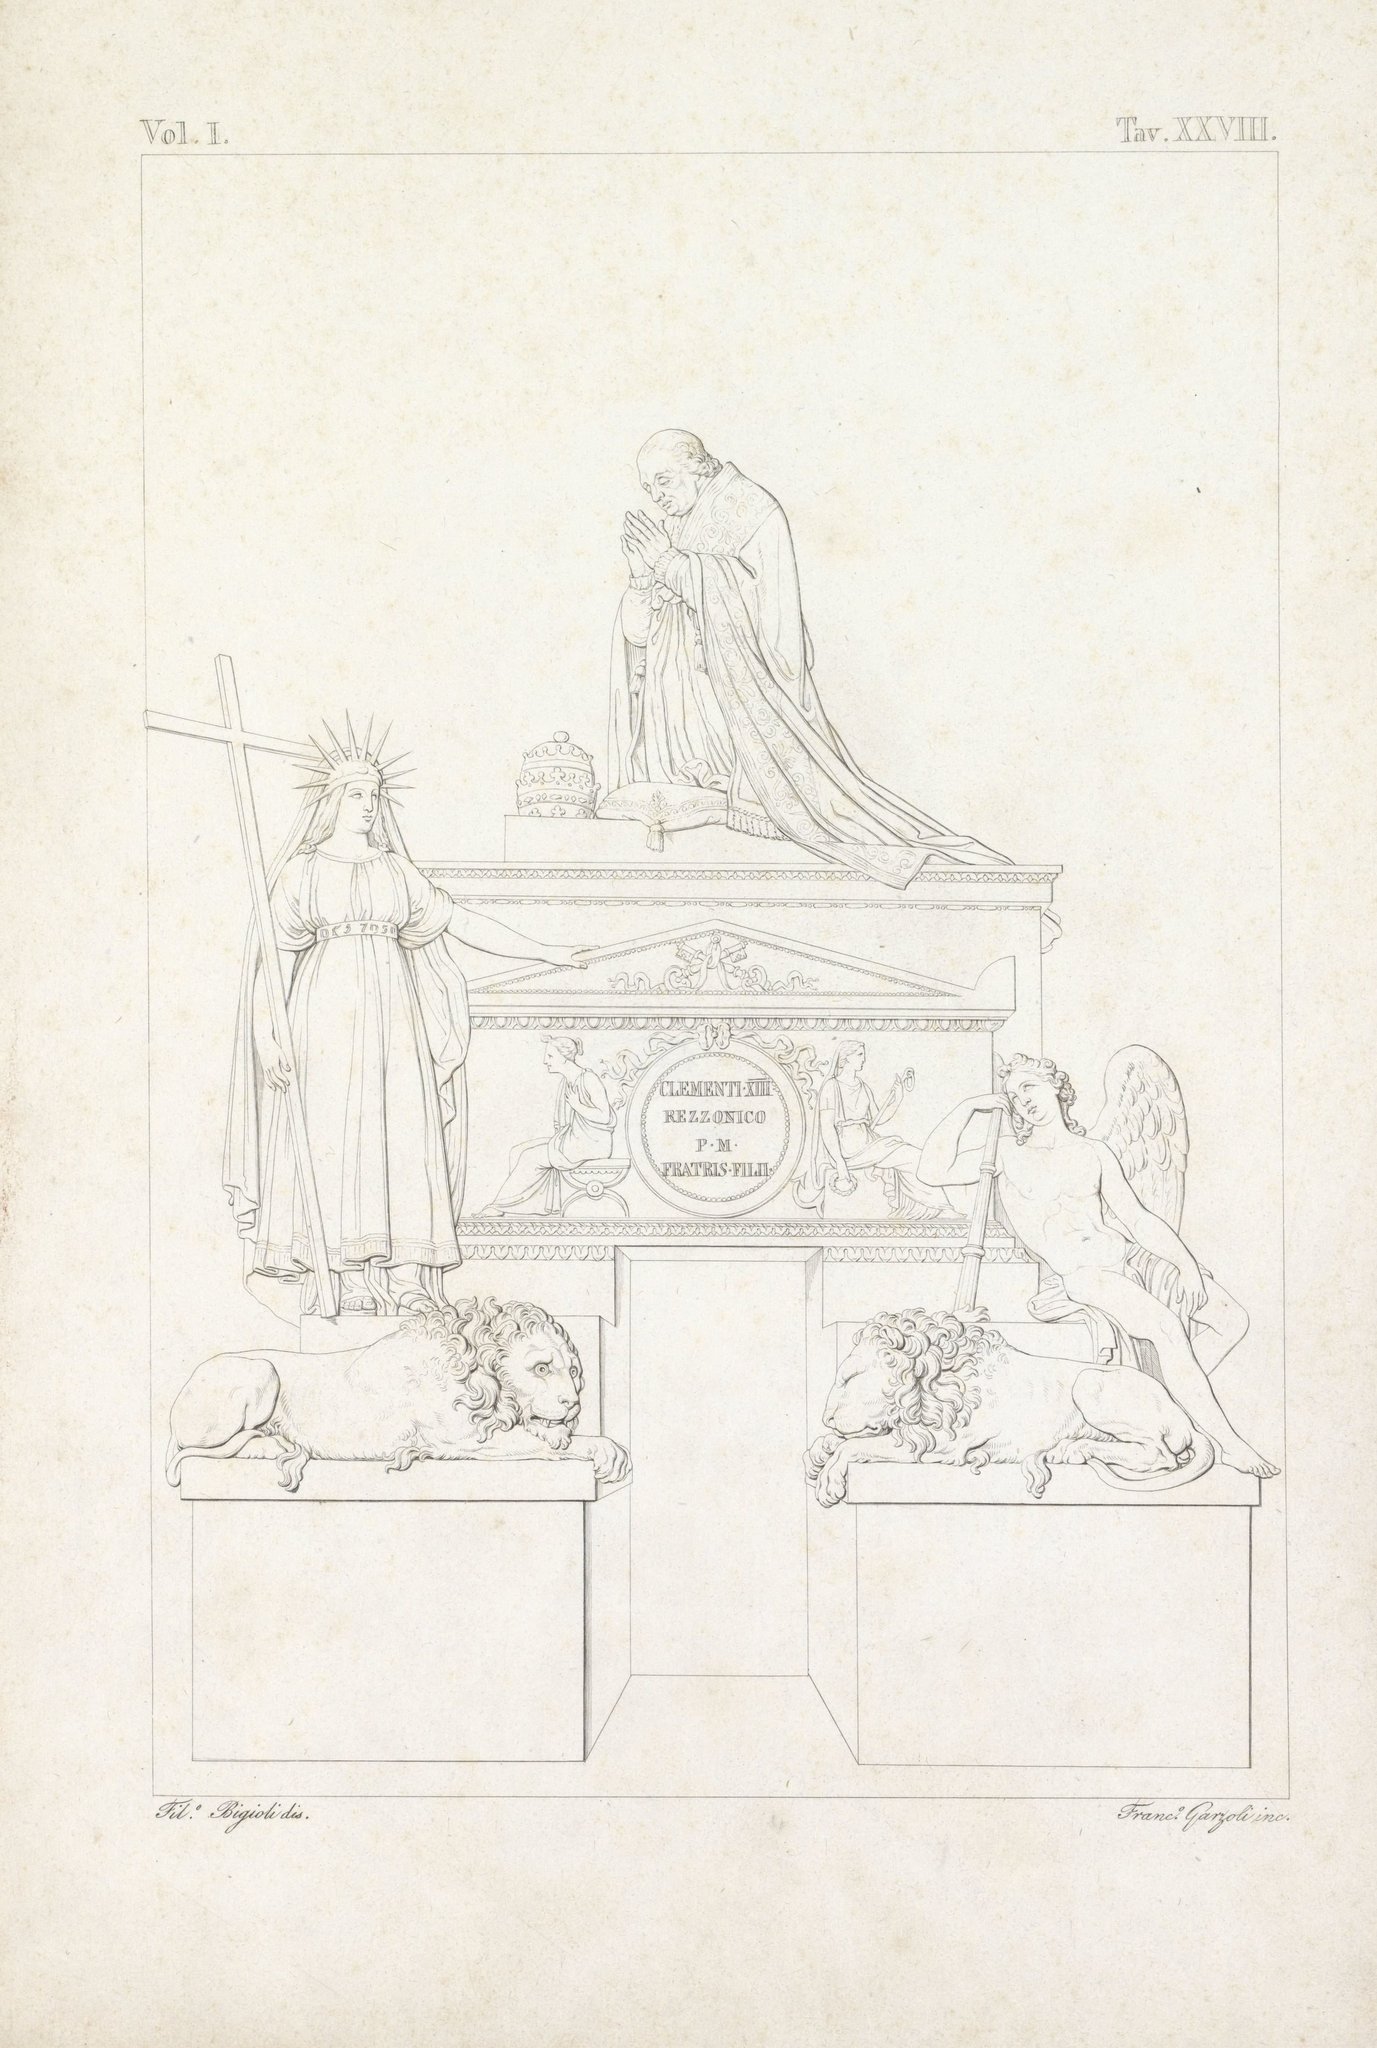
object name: print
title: Grafmonument van paus Clemens XIII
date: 1800-1899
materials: paper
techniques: etching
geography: italy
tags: clemens xiii, historical persons, grave, tomb, beasts of prey, predatory animals: lion, pope, angels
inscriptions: collector's mark: Lugt 2228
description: Grafmonument van paus Clemens XIII met twee leeuwen, een engel, een vrouw met kroon en kruis en een portret van de knielende paus Clemens XIII. Genummerd linksboven: Vol. 1, rechtsboven: Tav. XXVIII.